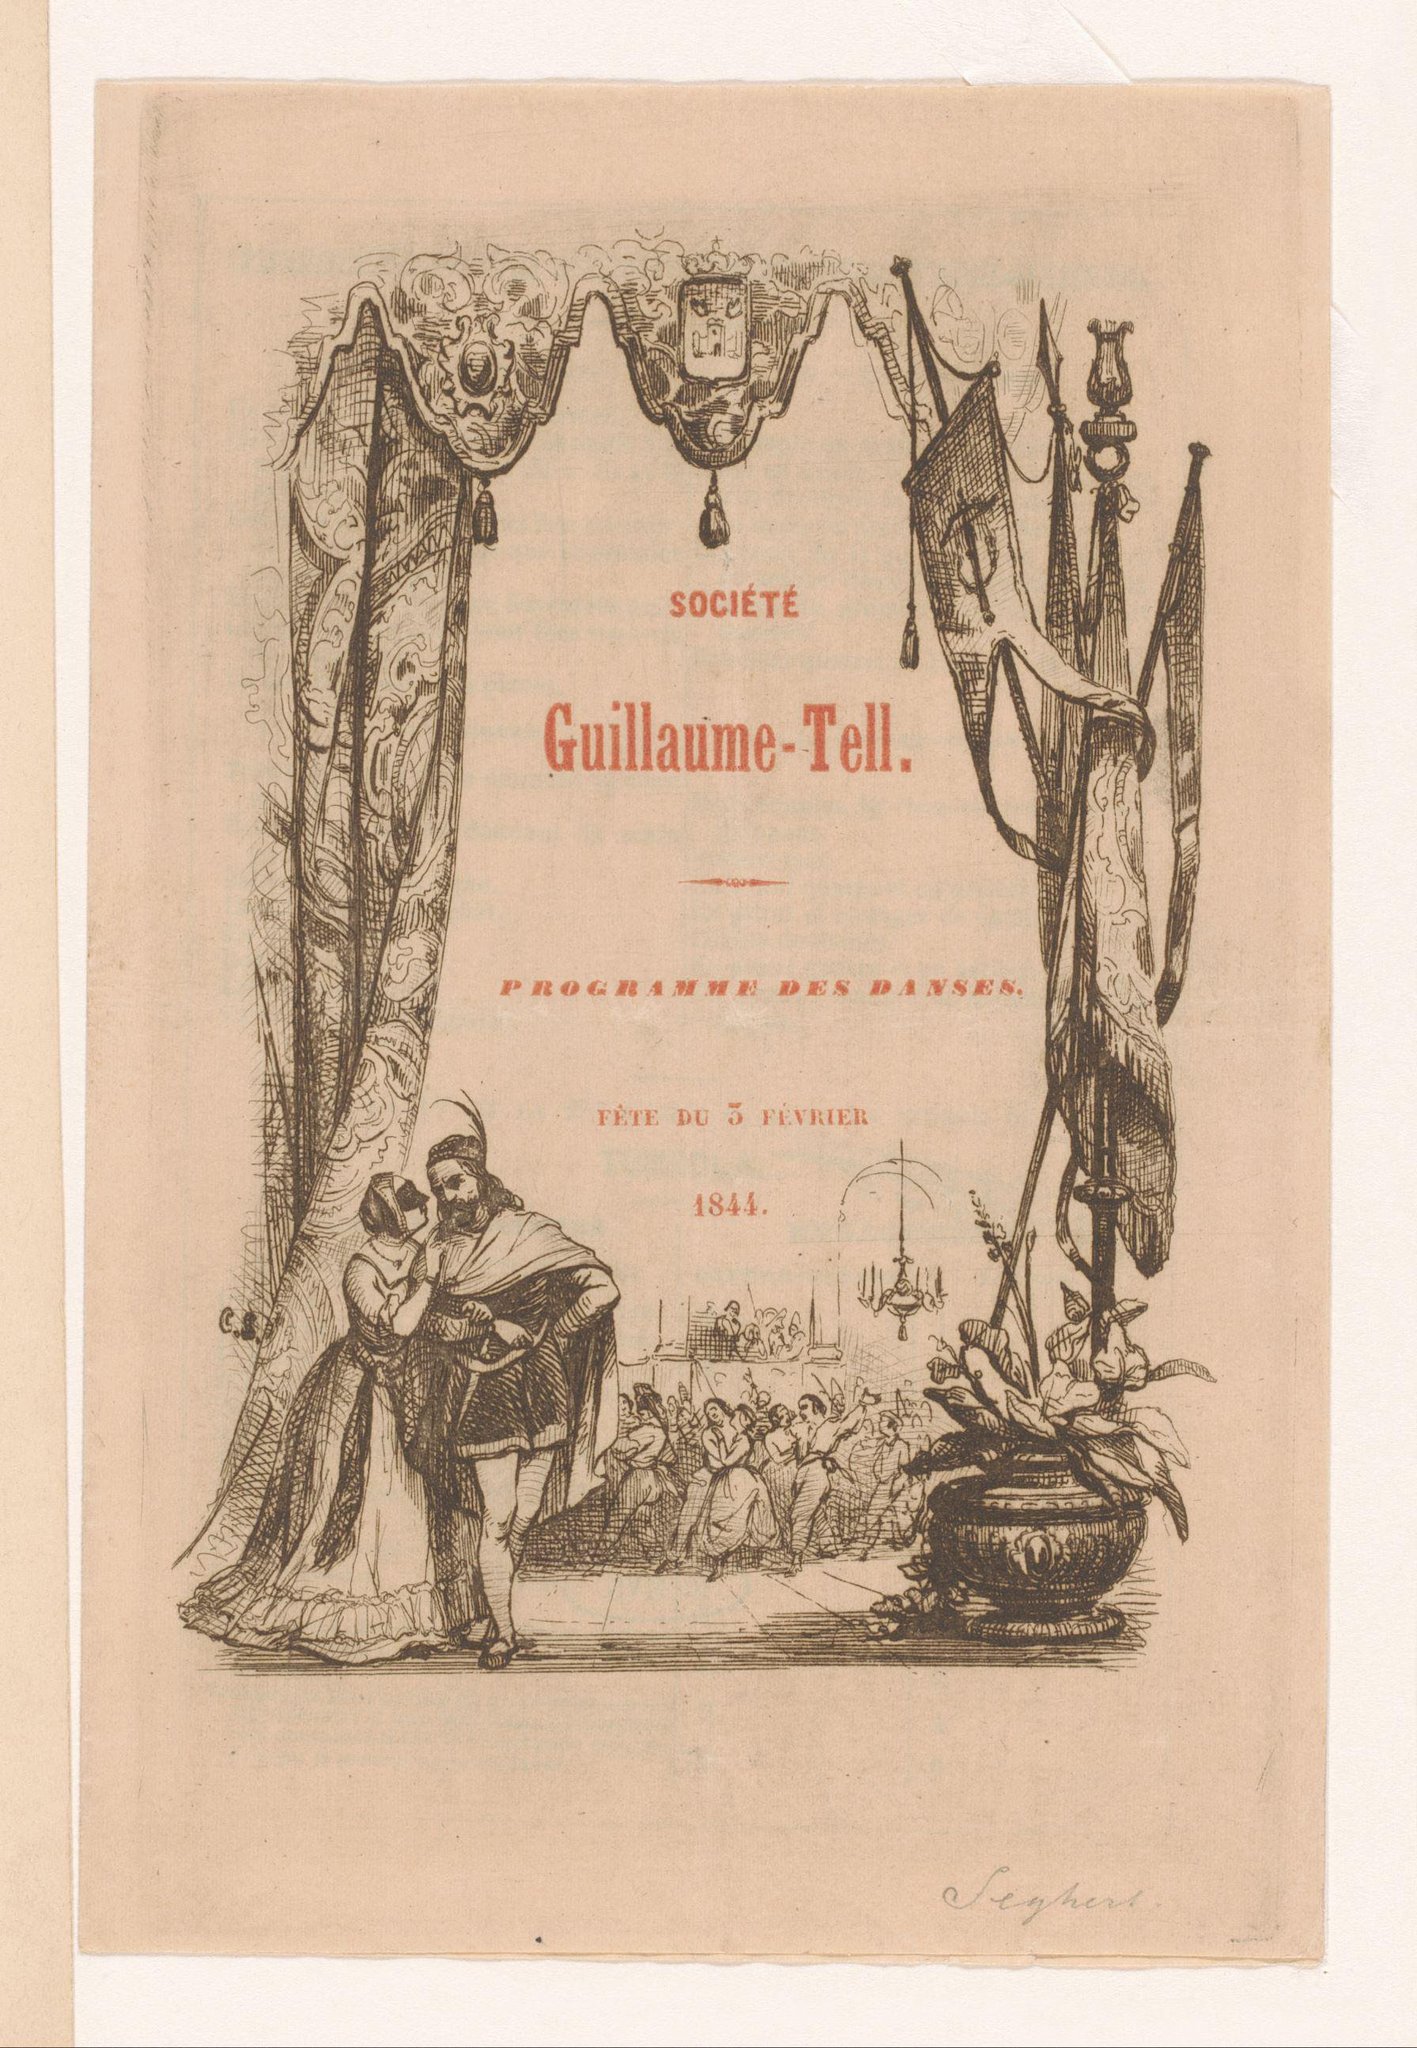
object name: print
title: Man en gemaskerde vrouw bij een danszaal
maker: corneille seghers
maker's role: draughtsman, print maker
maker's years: 1814-1869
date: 1844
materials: paper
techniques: etching, letterpress printing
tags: masquerade, masked ball, group dancing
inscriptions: collector's mark: Lugt 2228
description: Gevouwen blad met daarop het programma van een dansavond van de Société Guillaume-Tell. Van deze prent in de staat met de letter, bestaat nog een (bij Hippert & Linnig onbeschreven) versie waar dezelfde prent als uitnodiging dient. Zie RP-P-1913-2864.